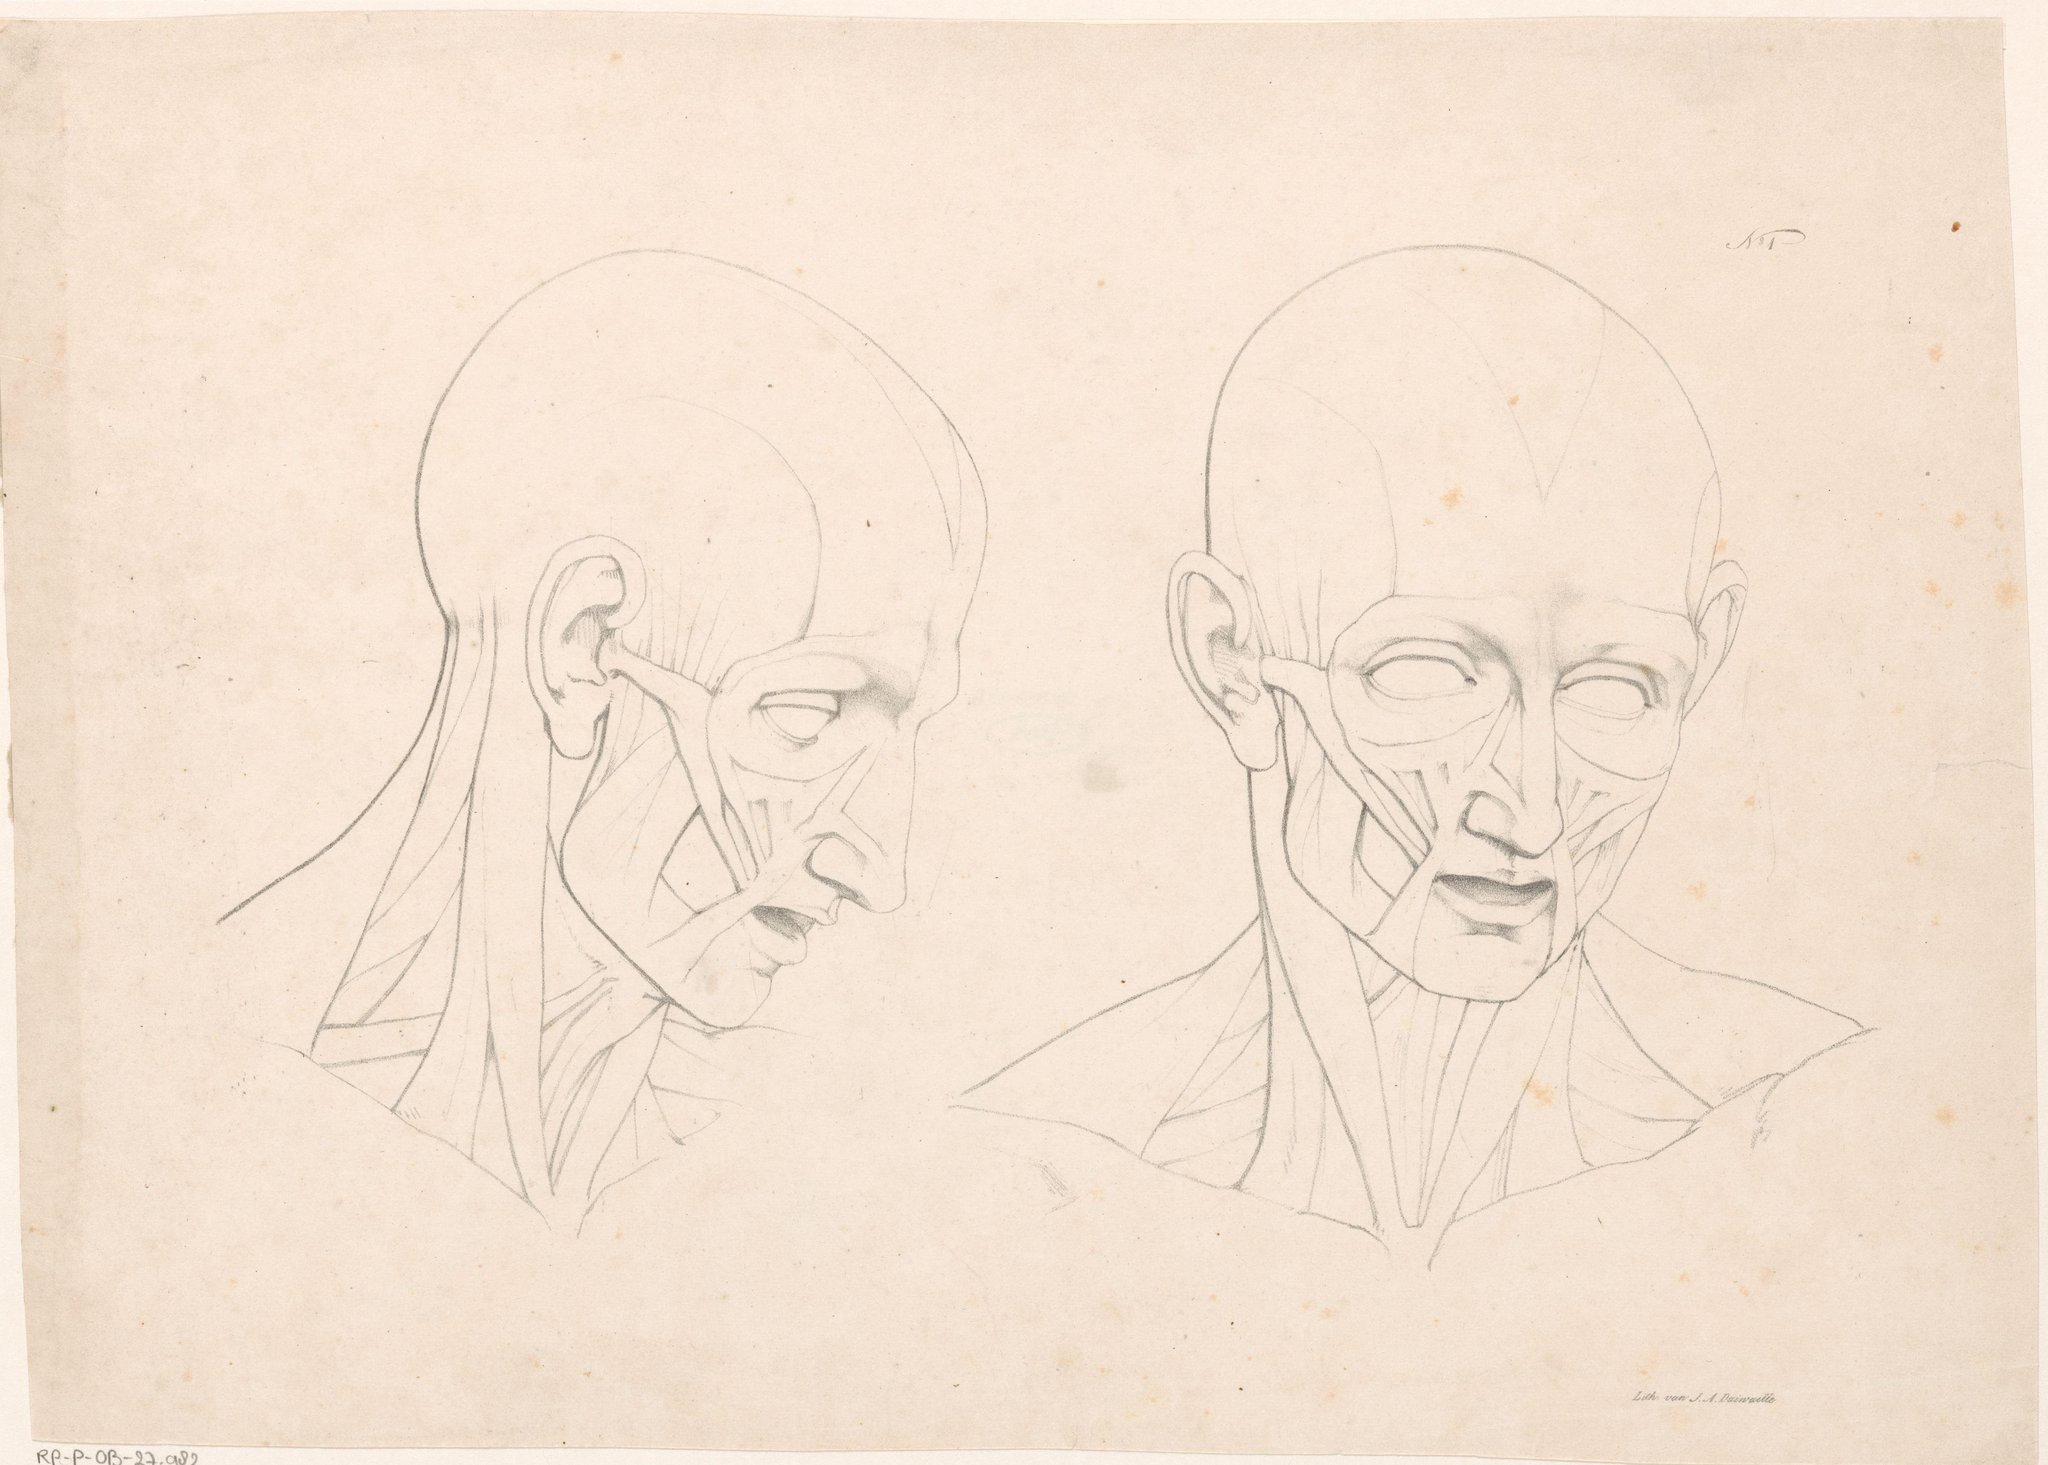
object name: print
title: Tekenvoorbeeld met twee hoofden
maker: jean augustin daiwaille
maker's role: draughtsman, print maker, printer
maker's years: 1786-1850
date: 1820-1833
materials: paper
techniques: lithograph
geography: amsterdam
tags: head (human) (+ three-quarter view), head (human) (+ sideview, profile), mouth slightly open, anatomical model of the muscles, muscle-man, 'écorché'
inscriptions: collector's mark: Lugt 2228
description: De hoofden bestaan uit spierbundels. Beiden hebben hun mond open. Genummerd rechtsboven: No. 1.